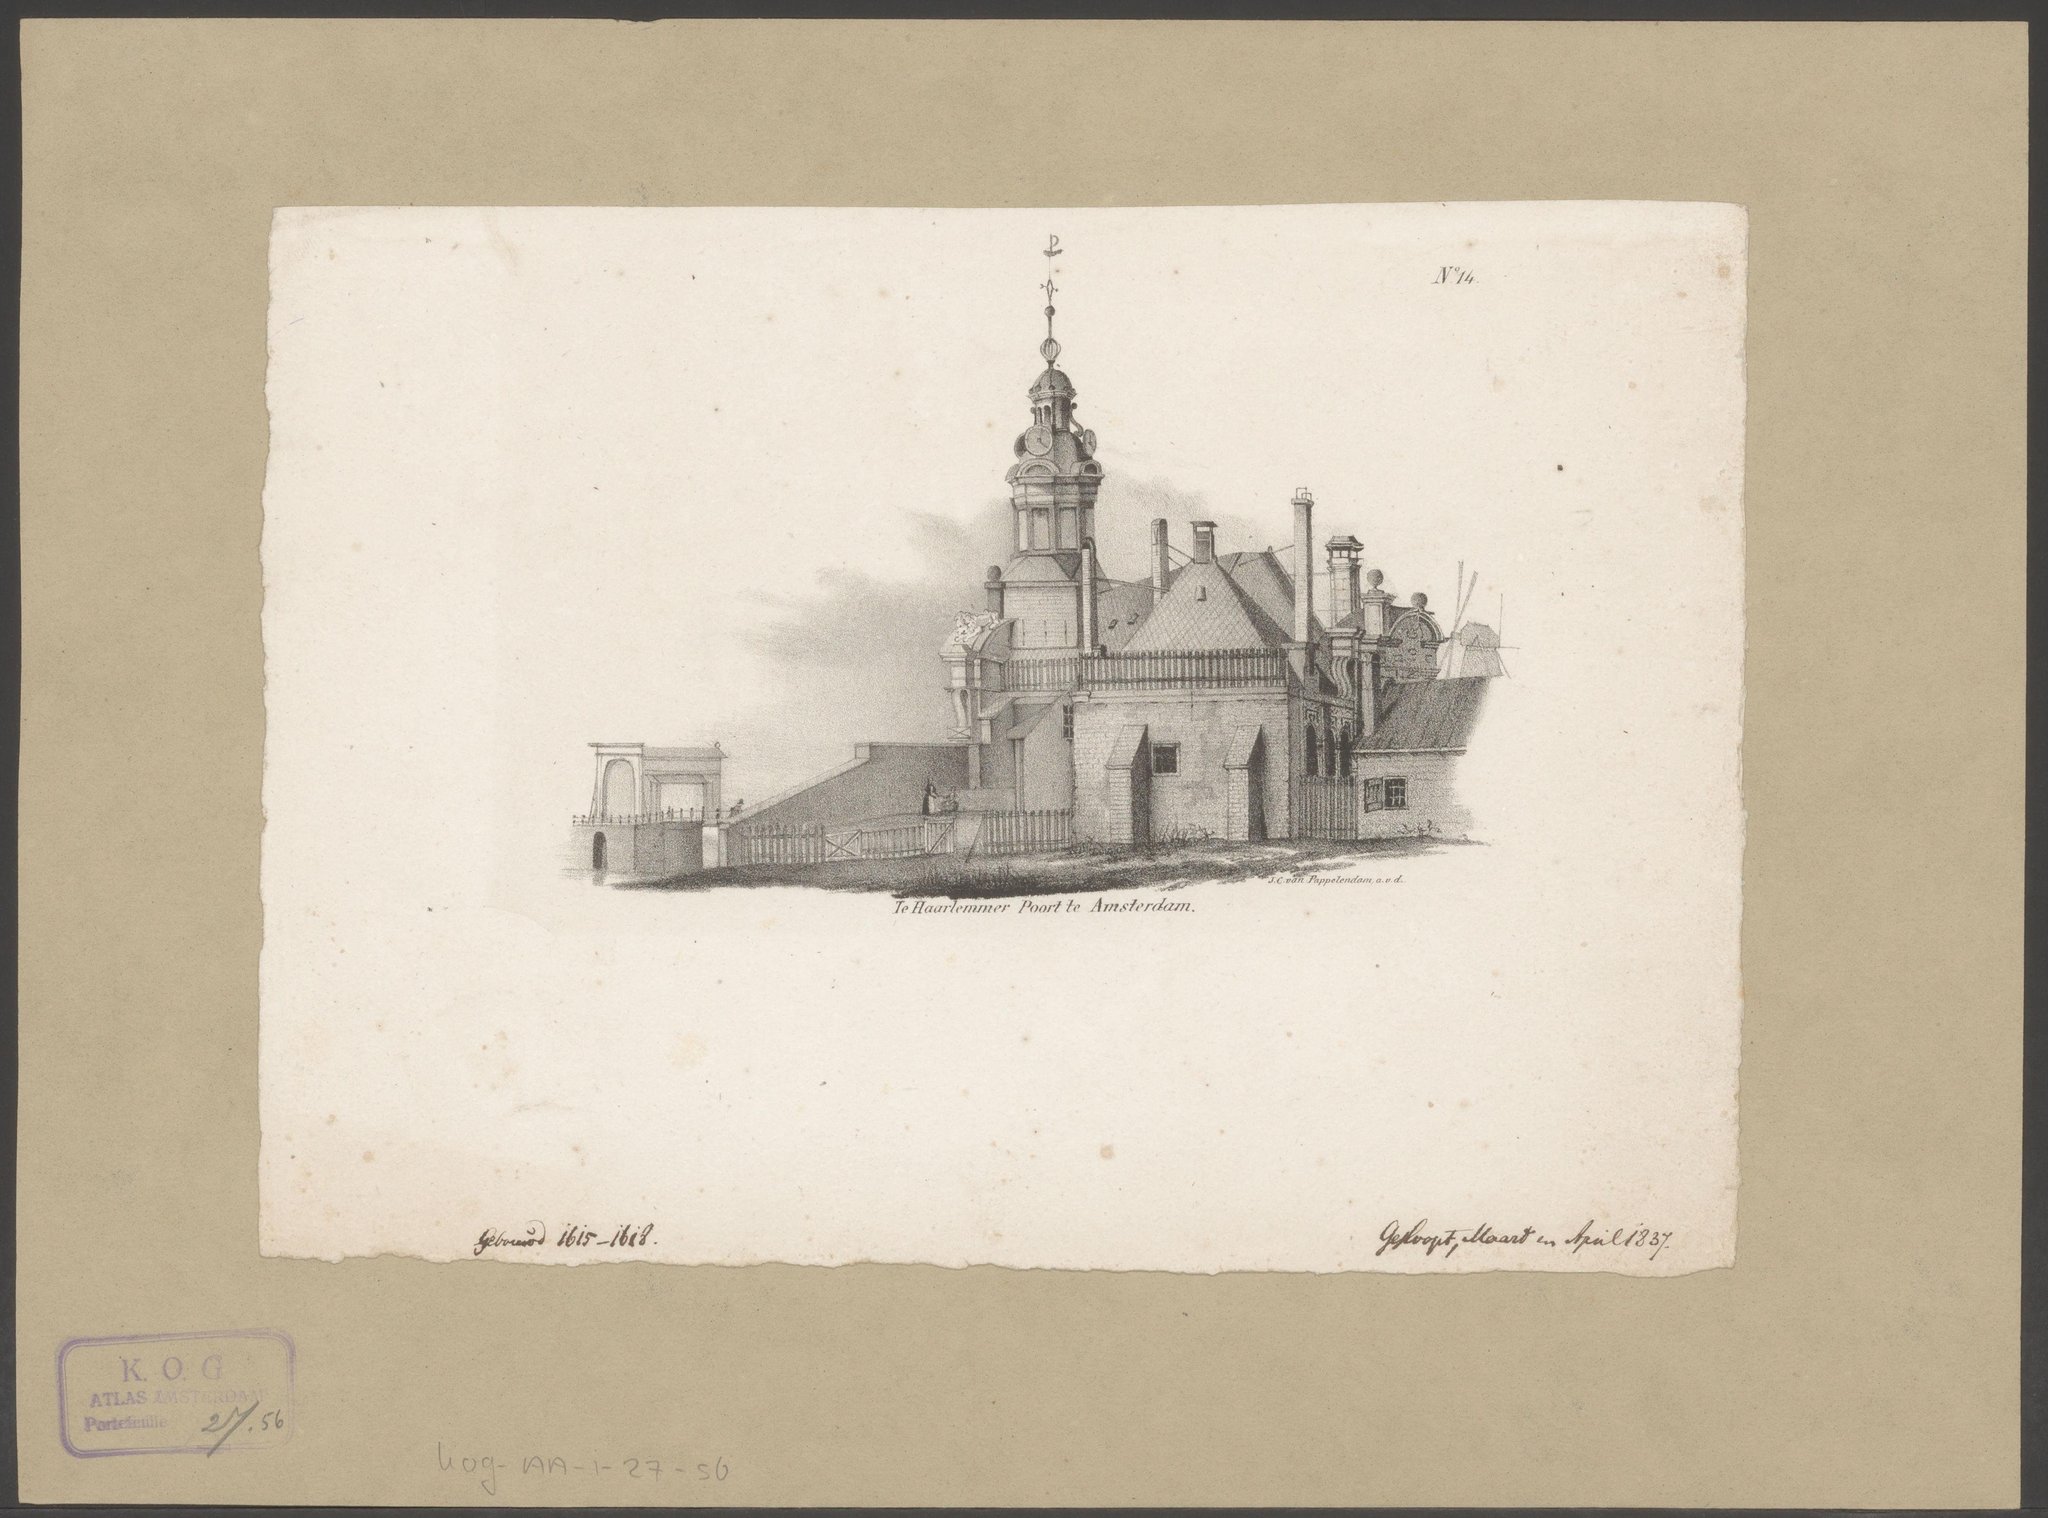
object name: book illustration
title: Dezelve van buiten te zien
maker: johannes cornelis van pappelendam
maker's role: print maker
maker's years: 1810-1884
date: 1825-1845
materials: paper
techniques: lithograph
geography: amsterdam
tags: city-gate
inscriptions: collector's mark: Lugt 1641b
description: Boven een gezicht op de Haarlemmerpoort te Amsterdam gezien vanuit de stad. Onder een gezicht op dezelfde poort en de bijhorende brug gezien van buiten de stad. Deze door Hendrik de Keyser ontworpen Haarlemmerpoort werd tussen 1615 en 1618 gebouwd. Rechtsboven genummerd: No. 14. Onderwerpsrubriek binnen de Atlas Amsterdam: B. Poorten, verzamelbladen, D. Haarlemmerpoort(en).